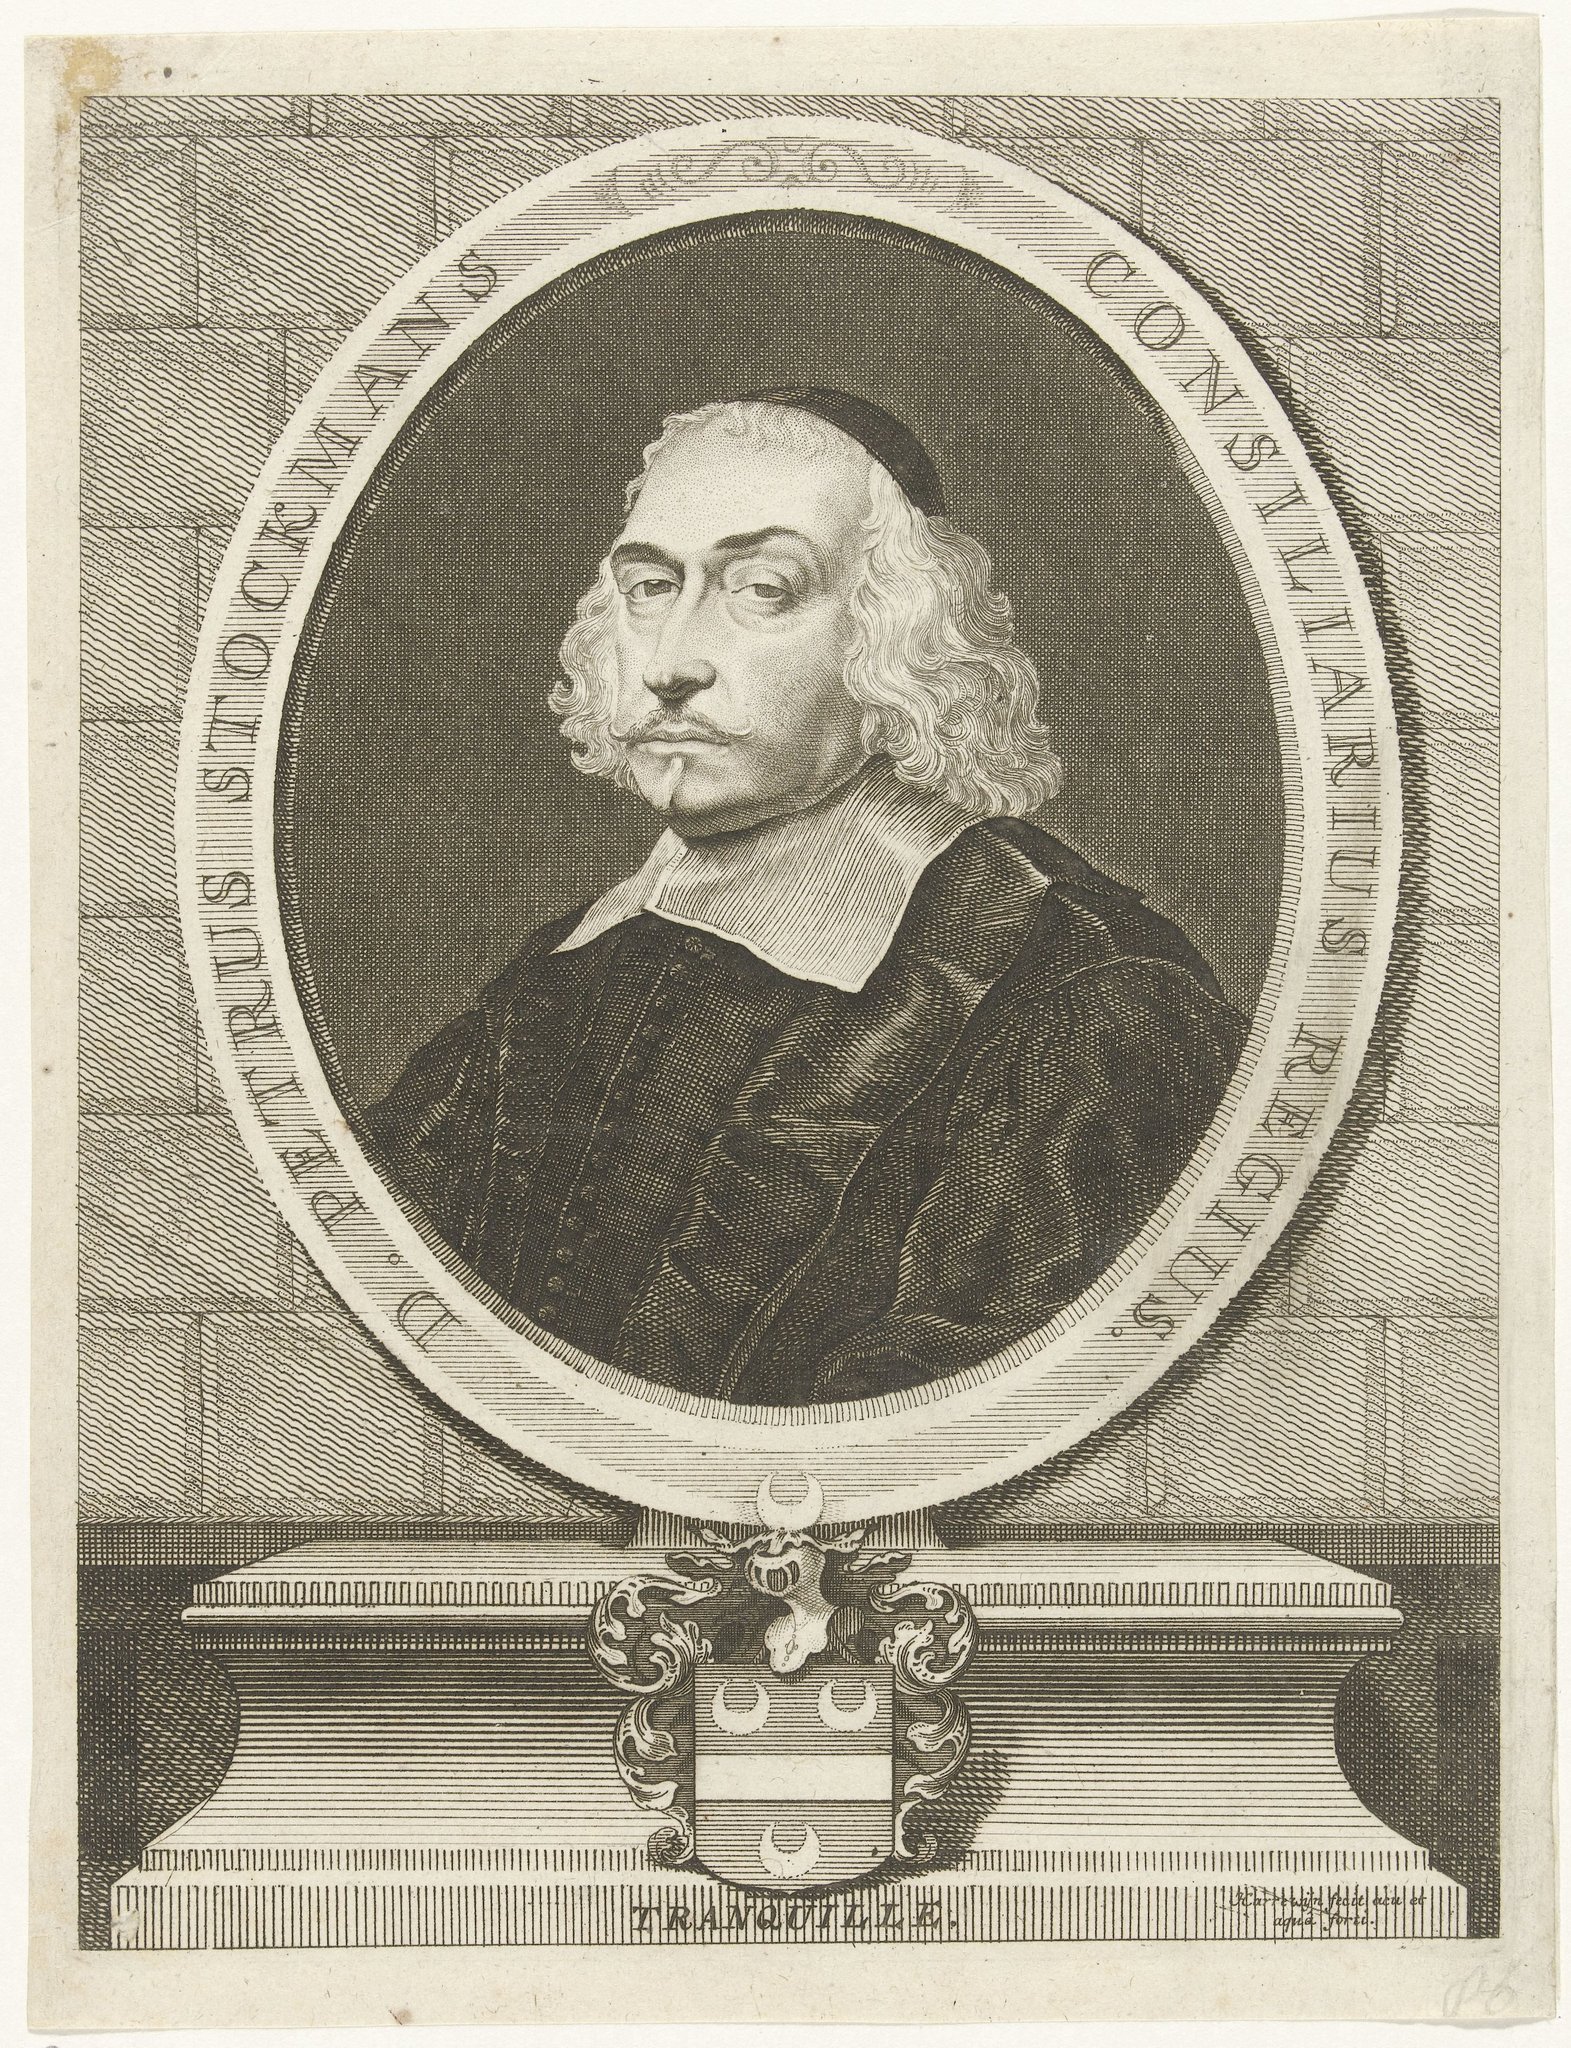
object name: print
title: Portret van Petrus Stockmans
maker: jacobus harrewijn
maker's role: print maker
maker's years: 1660-1740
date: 1698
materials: paper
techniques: engraving, etching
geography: brussels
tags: schrijver, petrus stockmans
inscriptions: collector's mark: Lugt 2228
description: Gebruikt als frontispice in 'Clarissimi Ac Amplissimi Viri D. Petri Stockmans [...] Opera Omnia [...]', Brussel c. 1698. Buste naar links van Petrus Stockmans in een ovaal. Onder zijn portret een wapen en het woord: tranquille.